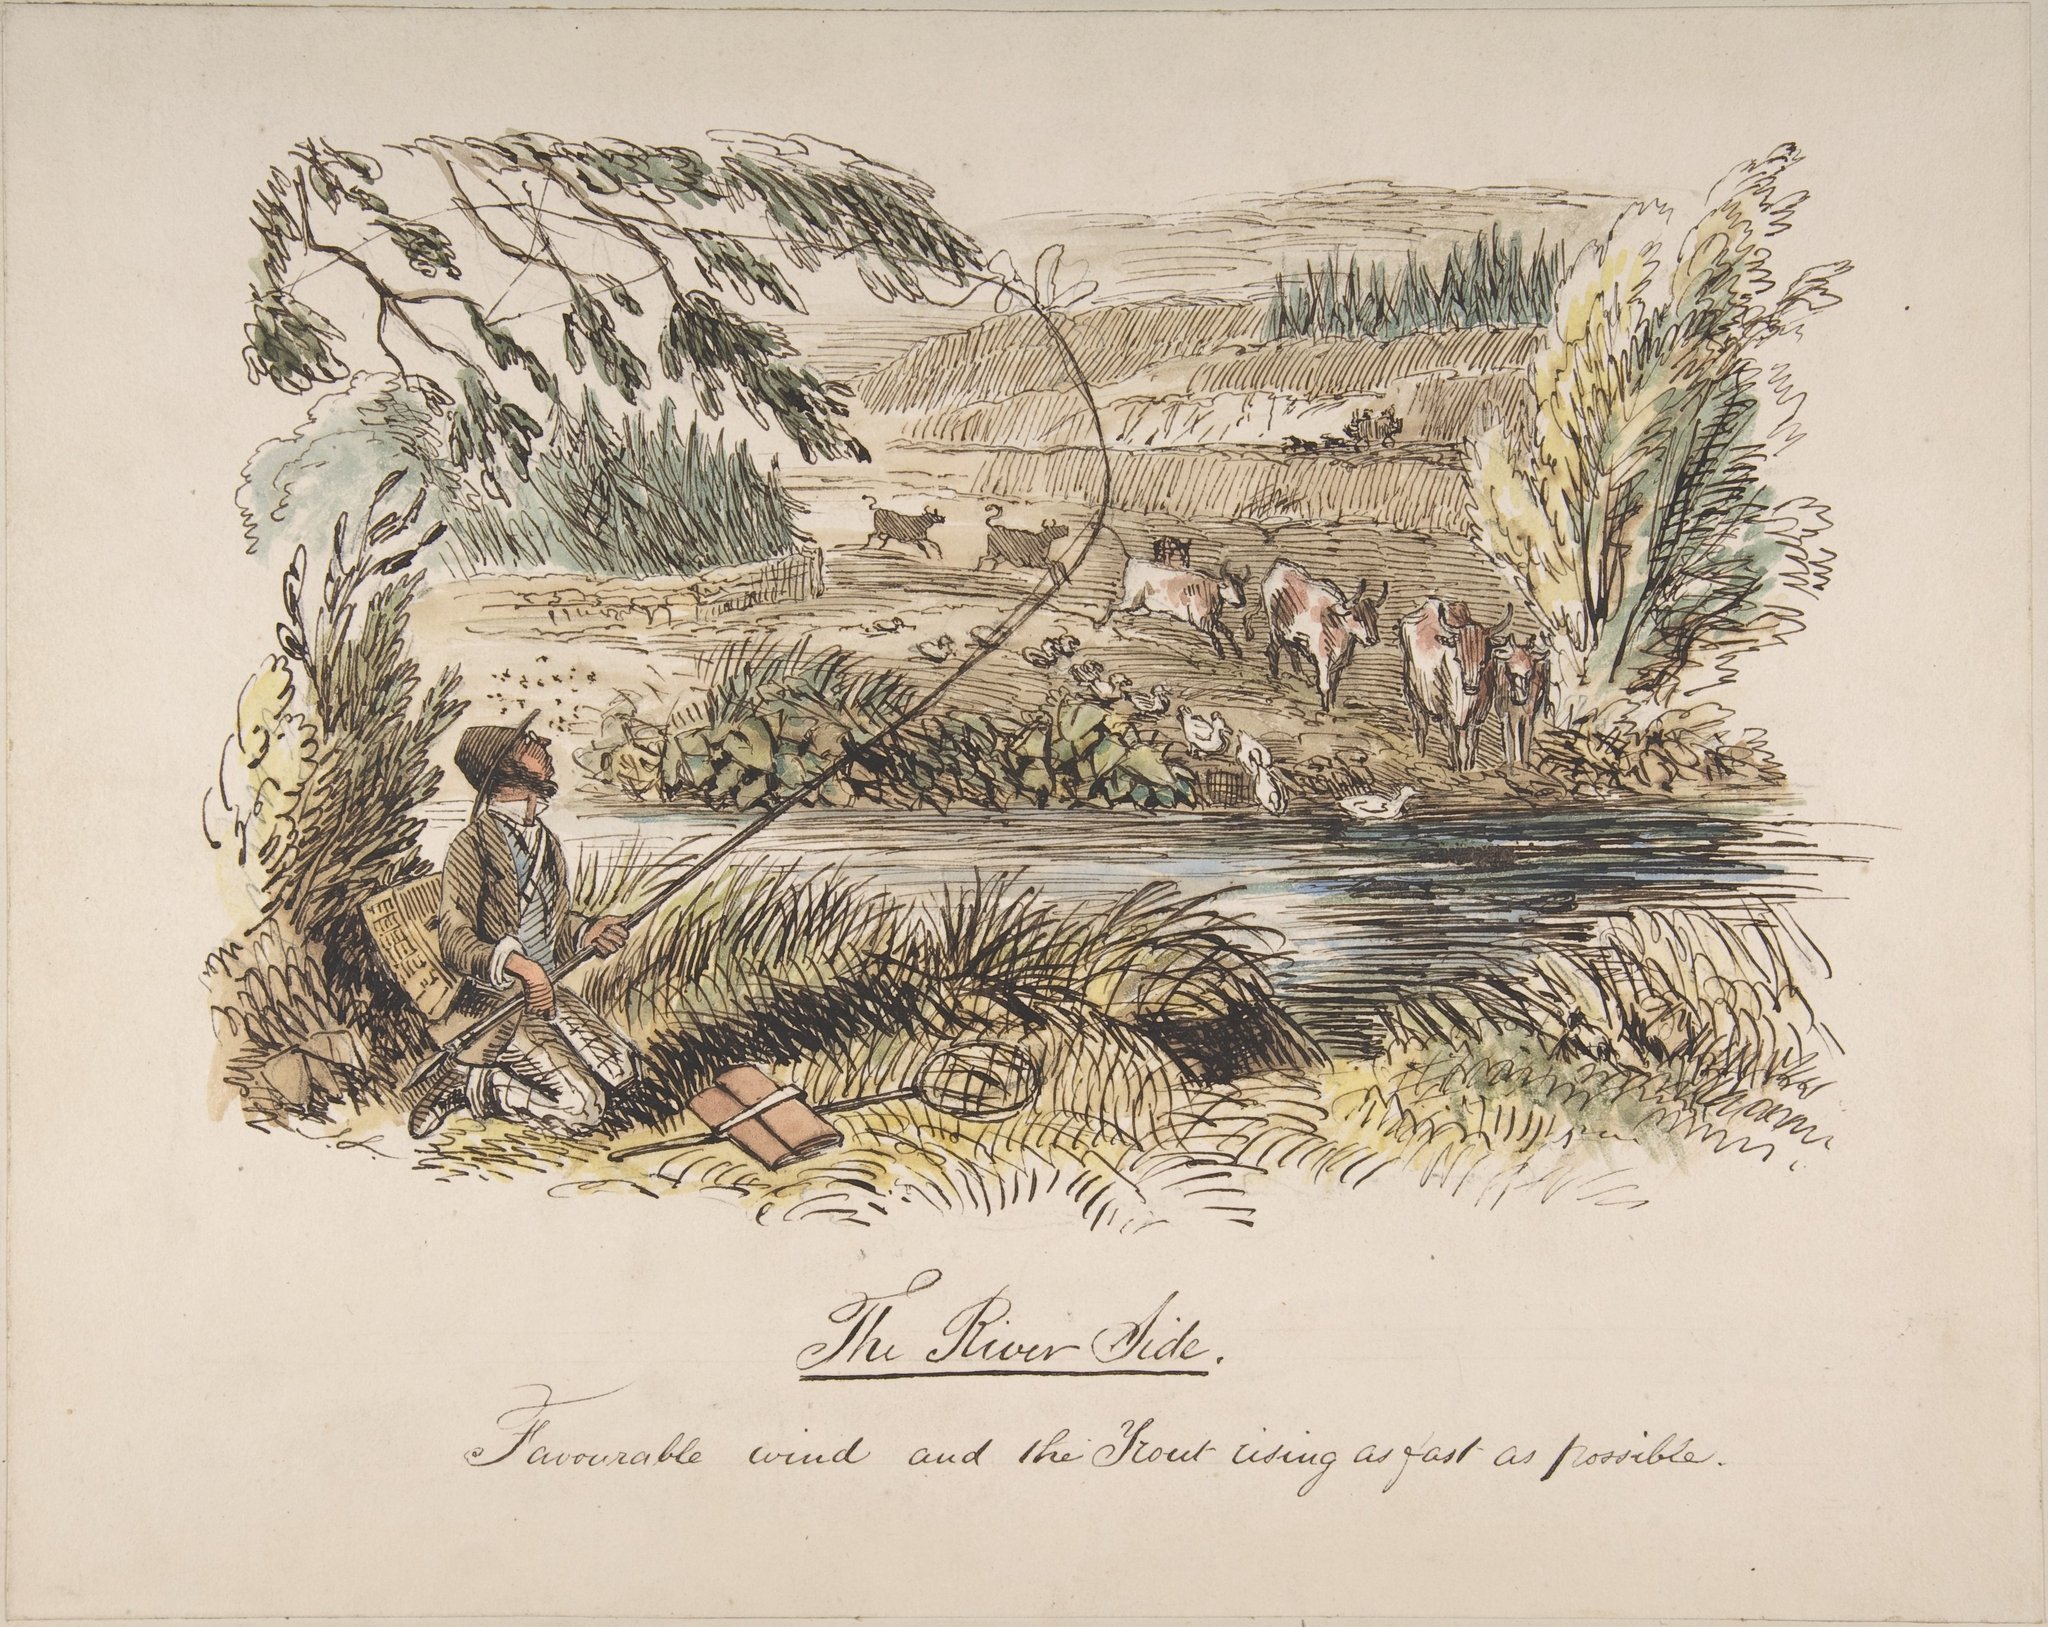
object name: drawing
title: "The Riverside, Favourable Wind and the Trout Rising as Fast as Possible"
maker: john leech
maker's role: artist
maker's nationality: british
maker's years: 1817-1864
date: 1830-1864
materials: graphite, ink, watercolor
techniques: pen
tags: animals,men,fishing,rivers,trees